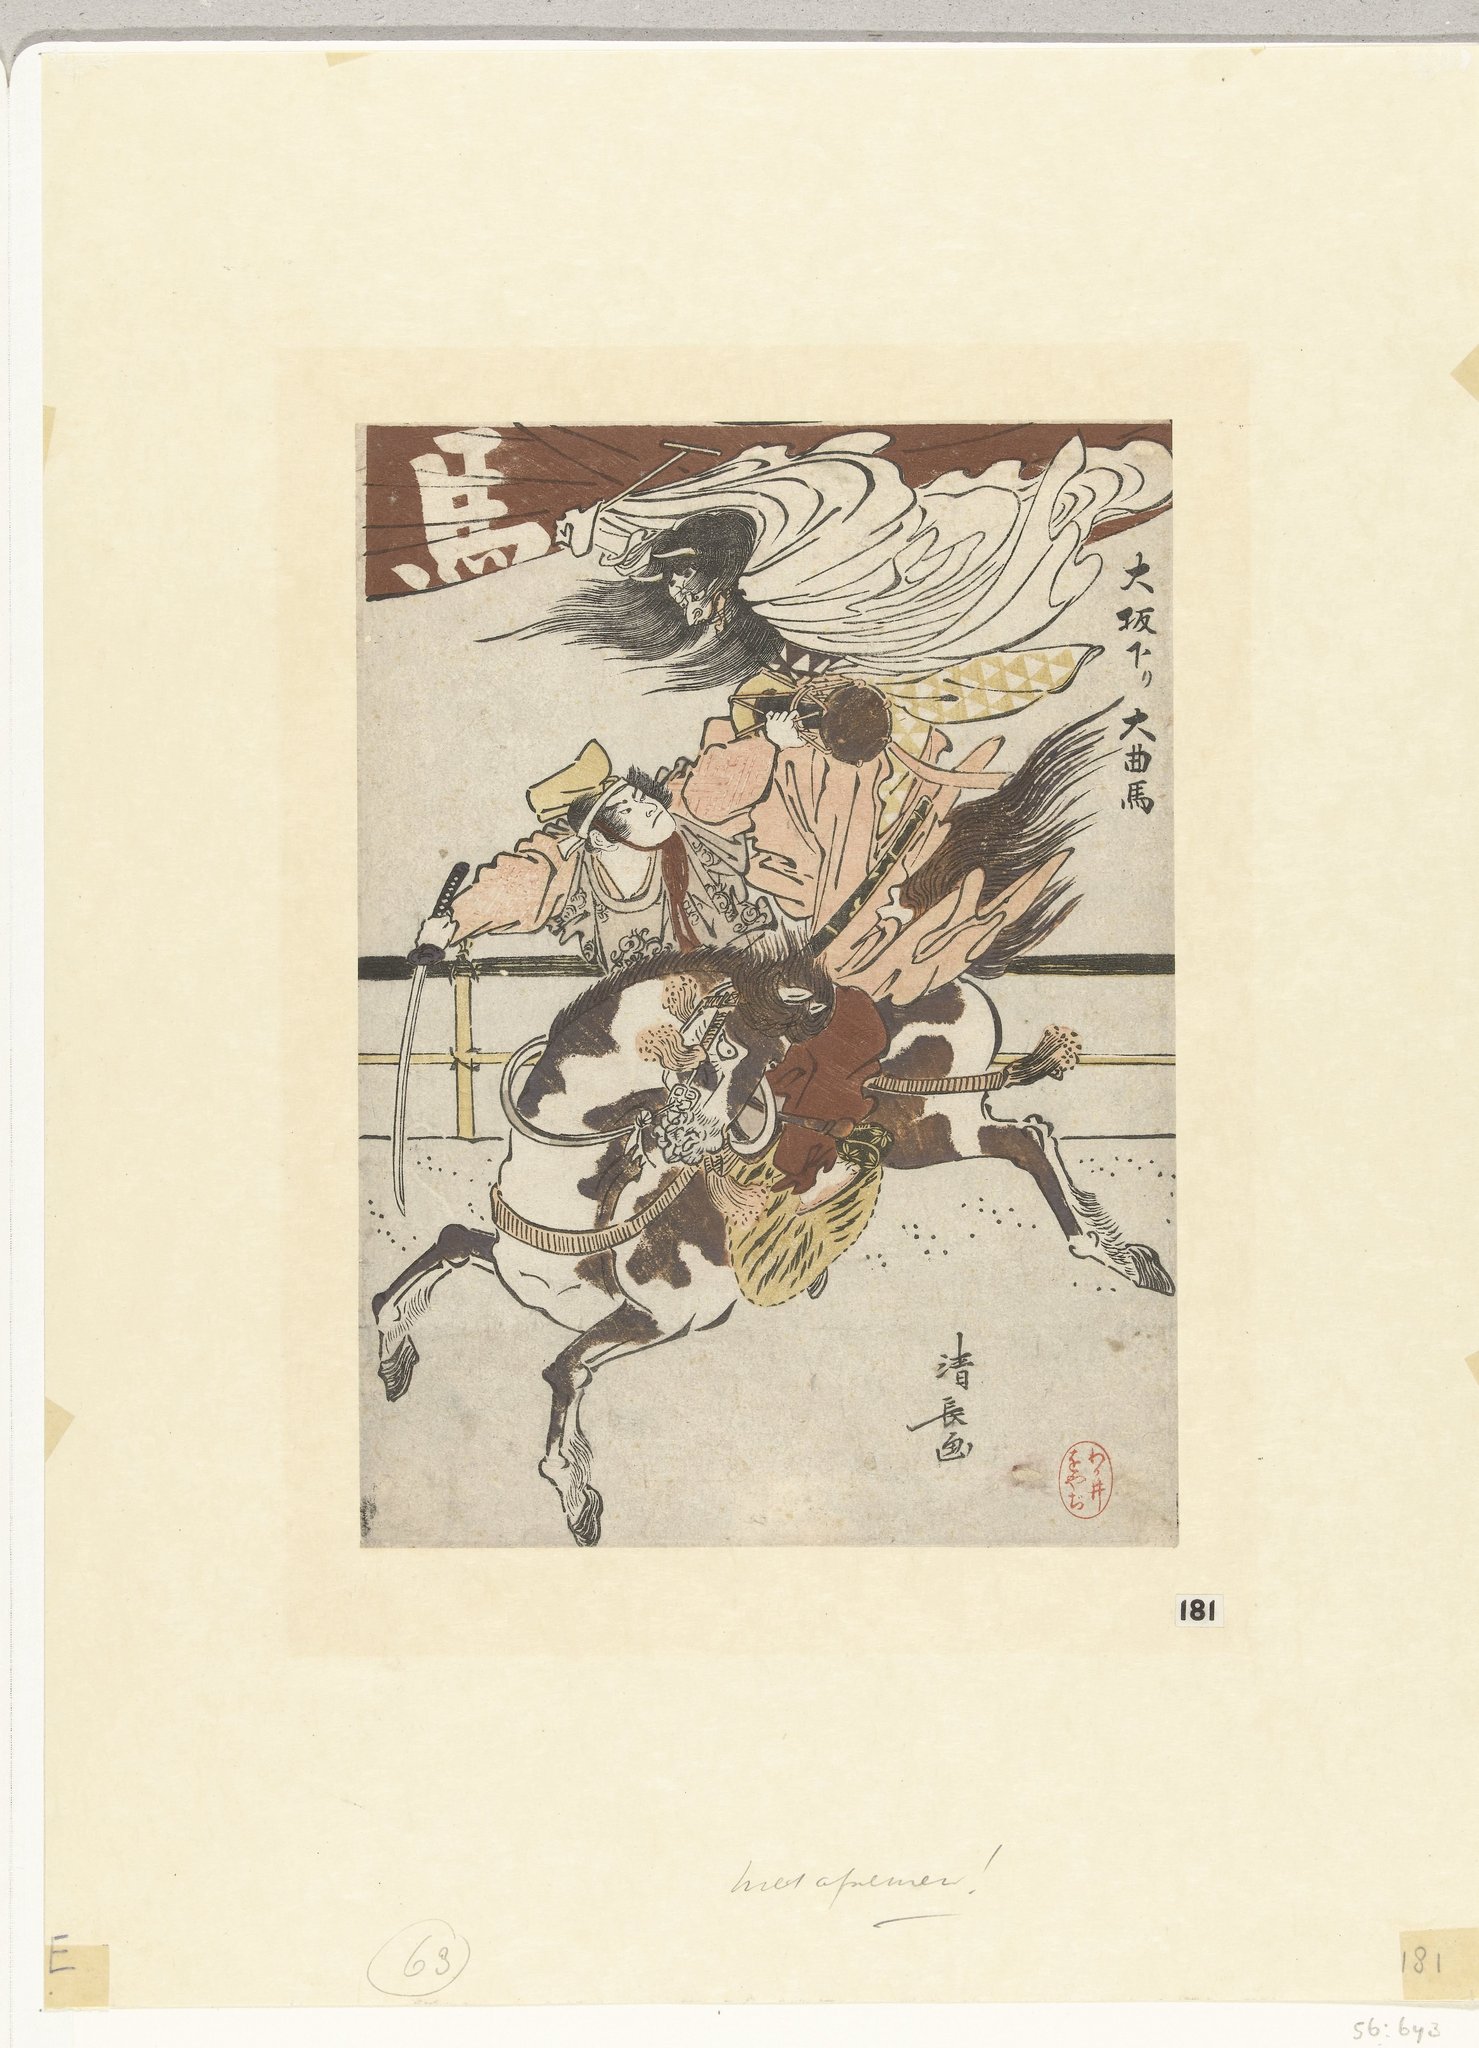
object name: print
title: Osaka kudari daikyokuba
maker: torii kiyonaga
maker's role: draughtsman, print maker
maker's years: 1752-1815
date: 1785-1790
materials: paper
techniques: woodcut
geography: japan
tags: circus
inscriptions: collector's mark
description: Man, gekleed als krijger, met zwaard in rechter en trommel in linker hand, op paard in gevecht met een hannya (jaloerse vrouwelijke geest).